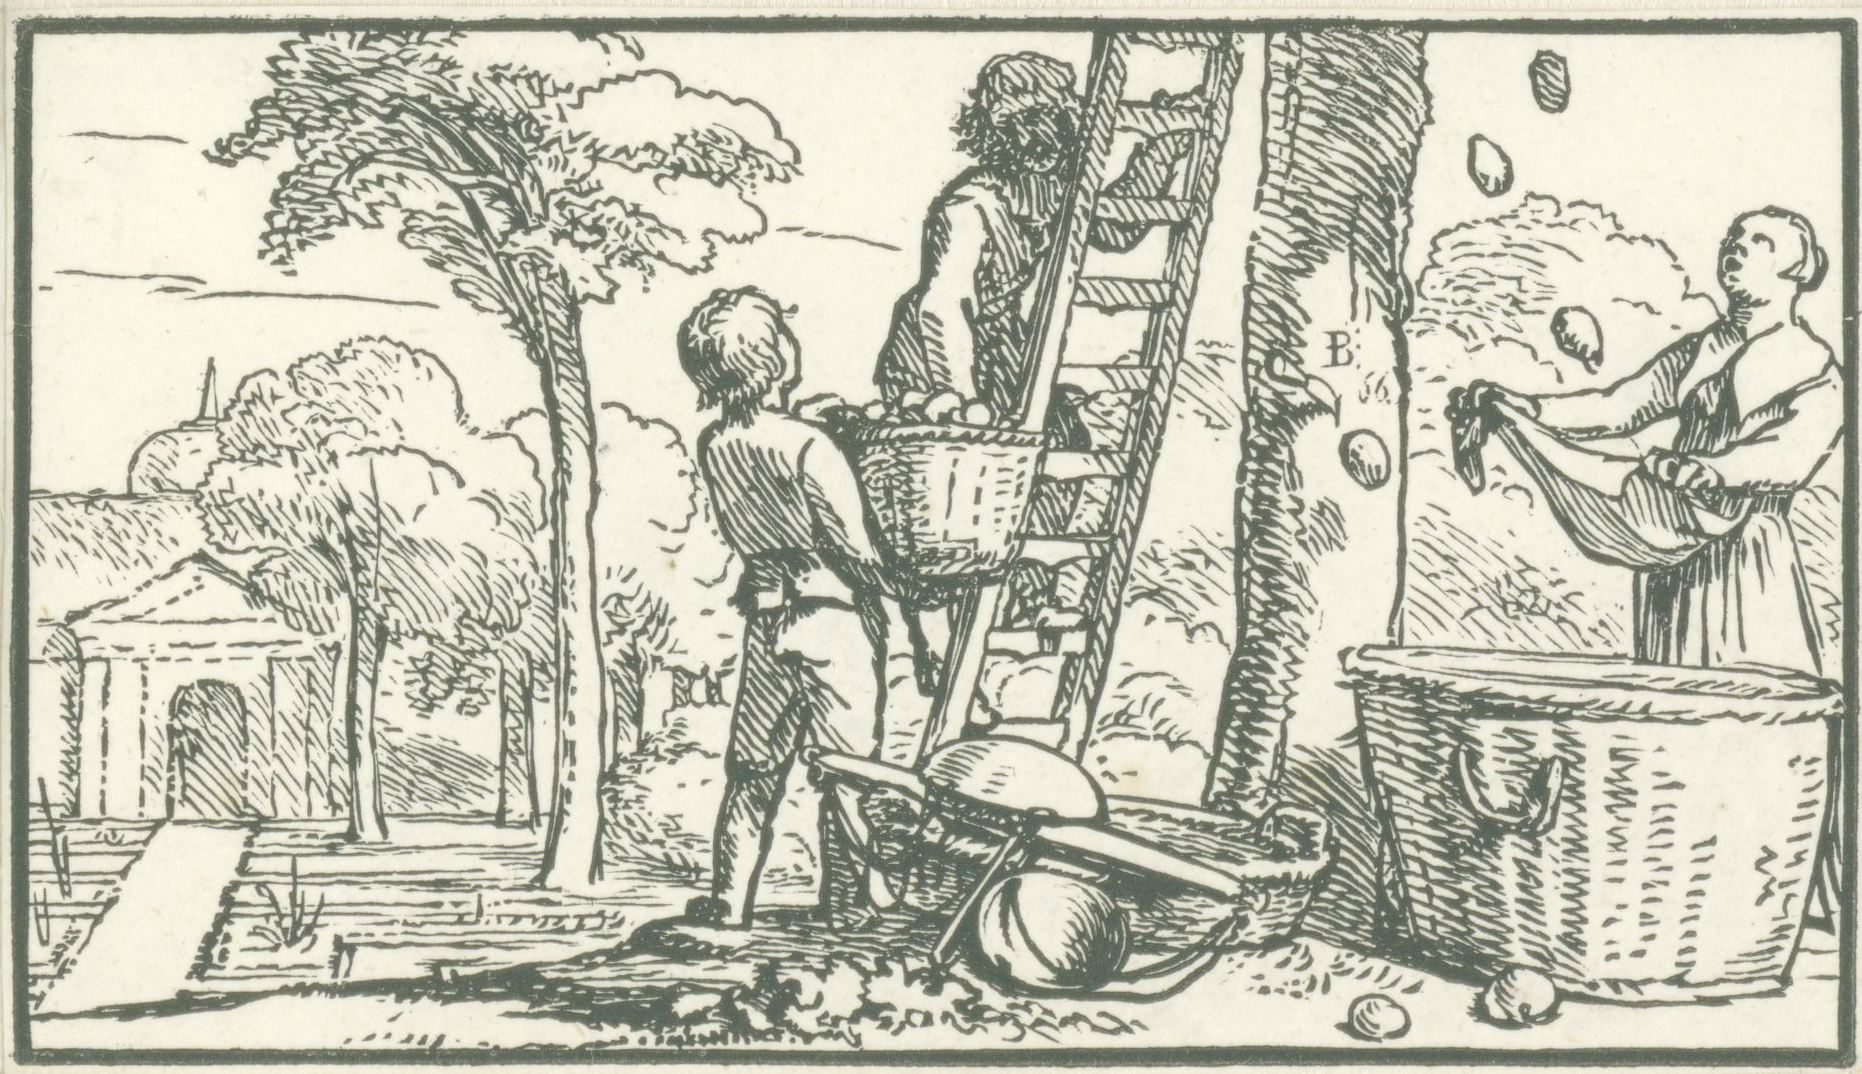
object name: print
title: September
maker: dirck de bray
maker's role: draughtsman, painter, print maker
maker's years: 1625-1694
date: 1635-1694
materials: paper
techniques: woodcut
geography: netherlands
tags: september and its 'labours' (+ with libra (september))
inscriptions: collector's mark: Lugt 240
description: Een man staat op een ladder tegen een boom. Een tweede man houdt een mand met vruchten voor hem omhoog. Rechts vangt een vrouw met haar schort vruchten uit de boom. Tegen de ladder ligt een weegschaal.